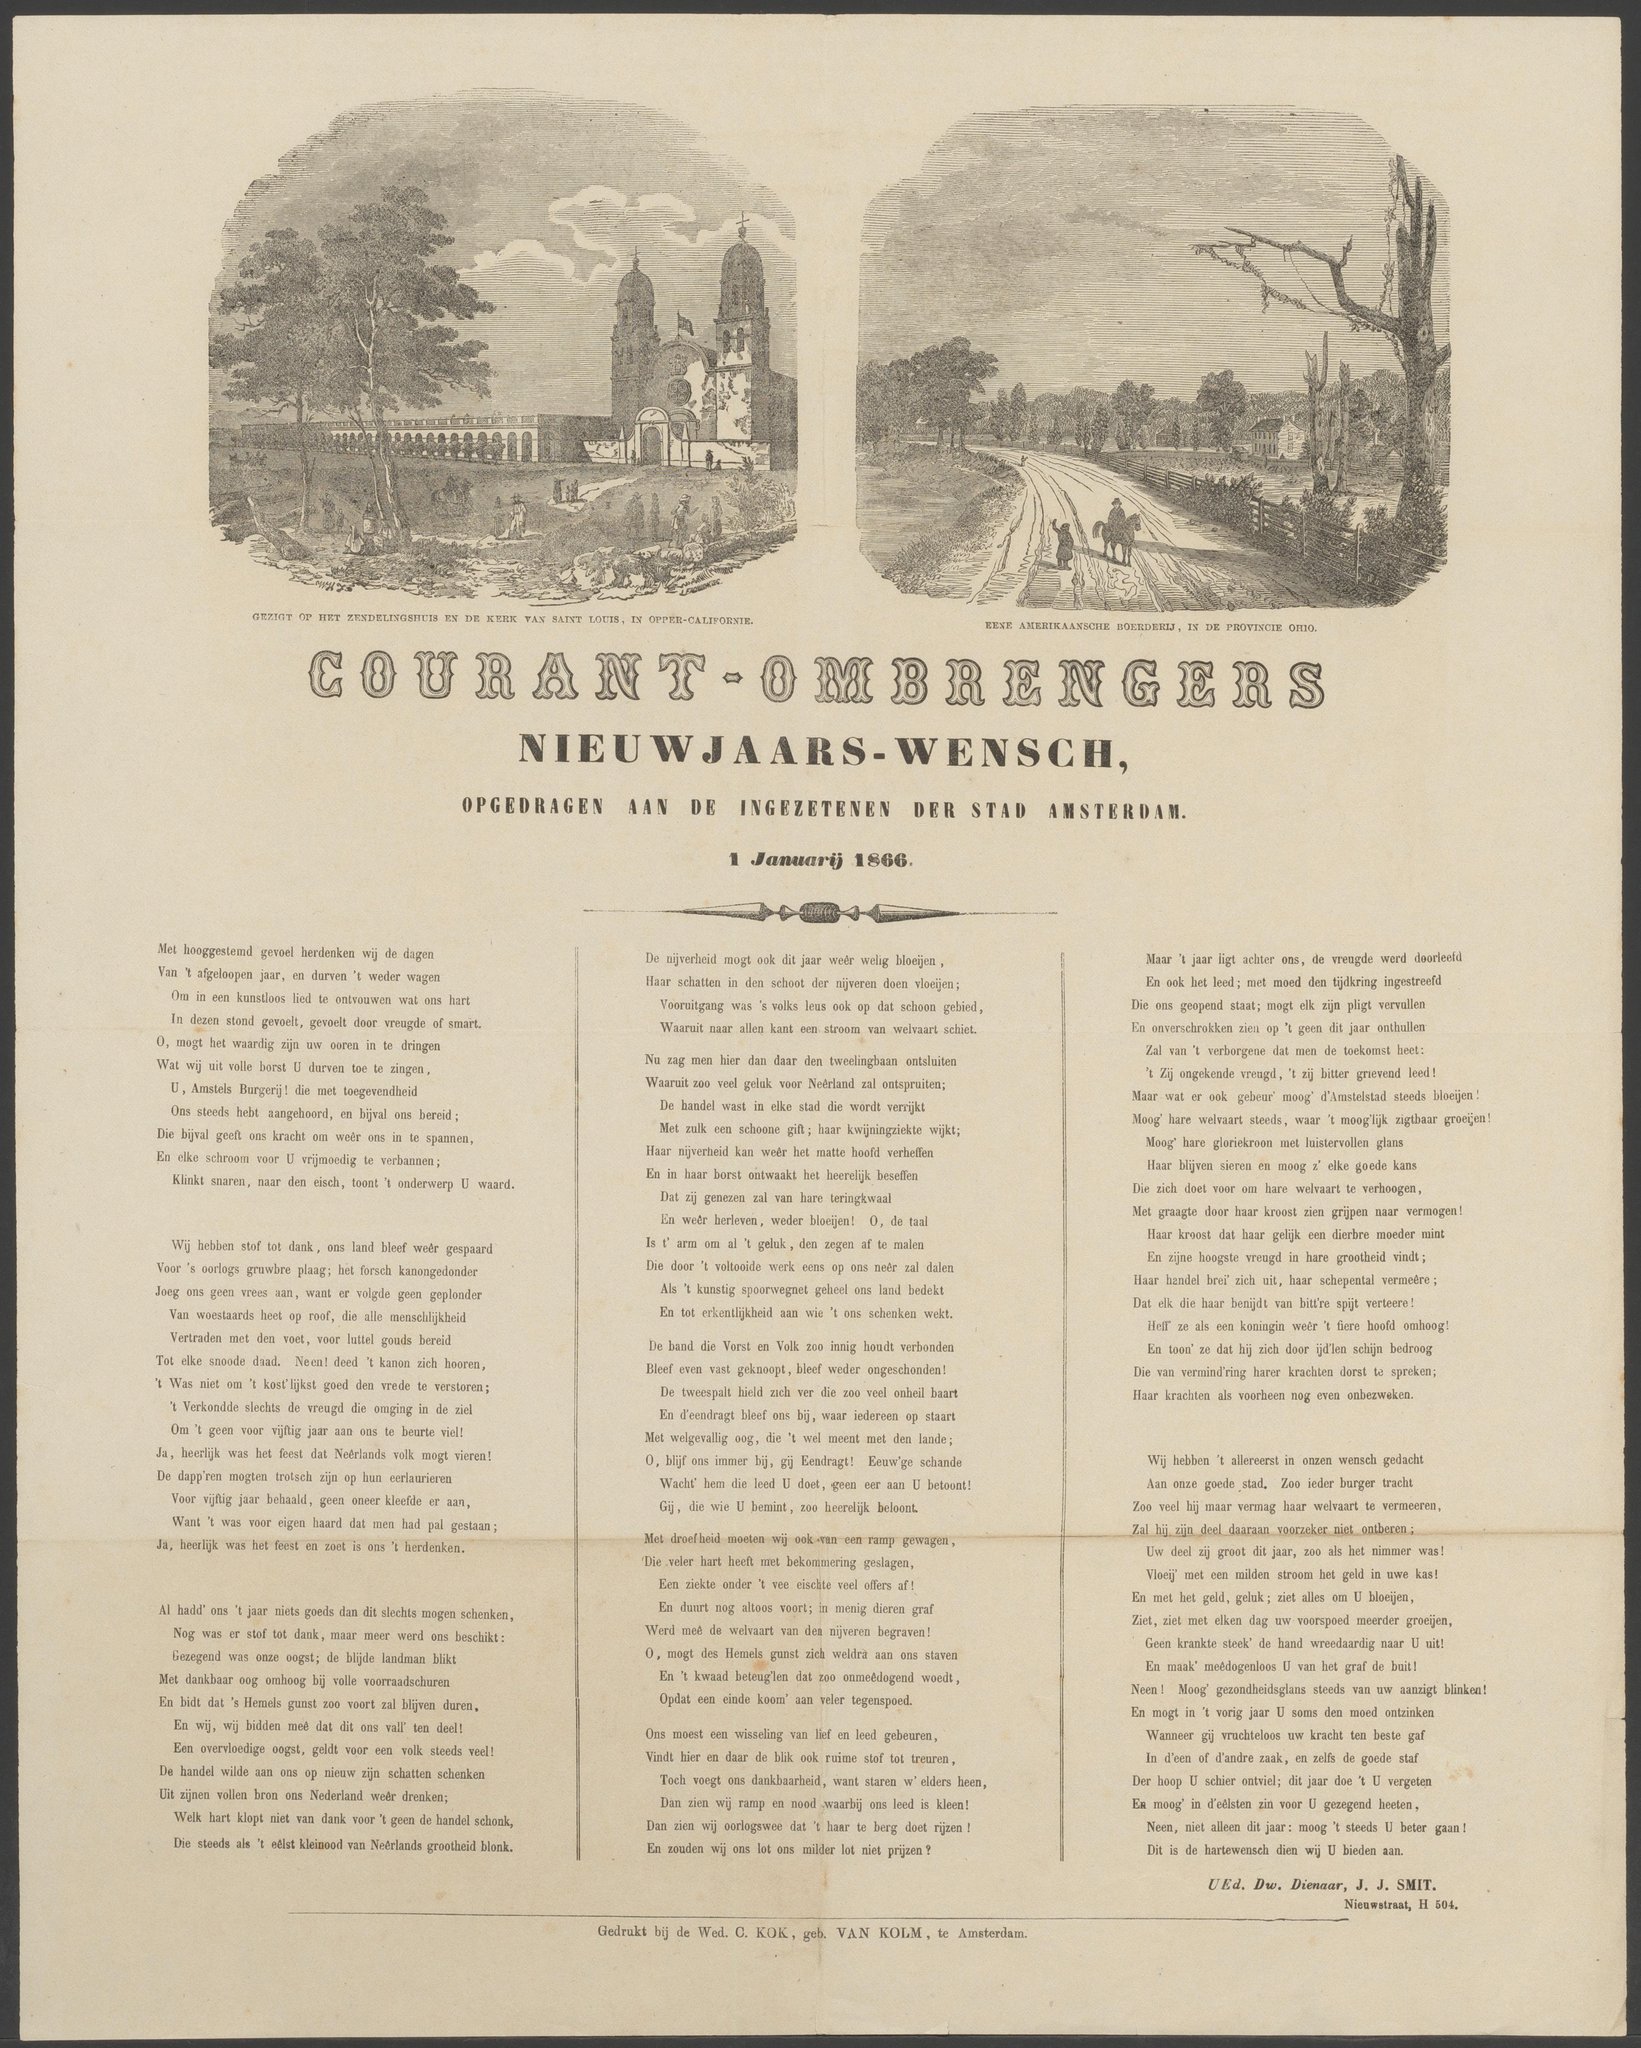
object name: print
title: Nieuwjaarswens van de Amsterdamse courantombrengers voor het jaar 1866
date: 1866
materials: paper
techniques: letterpress printing, engraving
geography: amsterdam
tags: church (exterior), farm (building)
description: Nieuwjaarswens namens de ombrengers van couranten (krantenbezorgers) te Amsterdam, 1866. Bovenaan twee vignetten, links het zendelingenhuis in Californië en rechts een Amerikaanse boerderij. Onderaan een gedicht in drie kolommen. Van de courantombrenger: J.J. Smit. Onderwerpsrubrieken binnen de Atlas Zeden en Gewoonten: Zeden en gewoonten in engeren zin, Volksleven, Volksbladen, Nieuwjaars- en Kerstwenschen, Amsterdam.